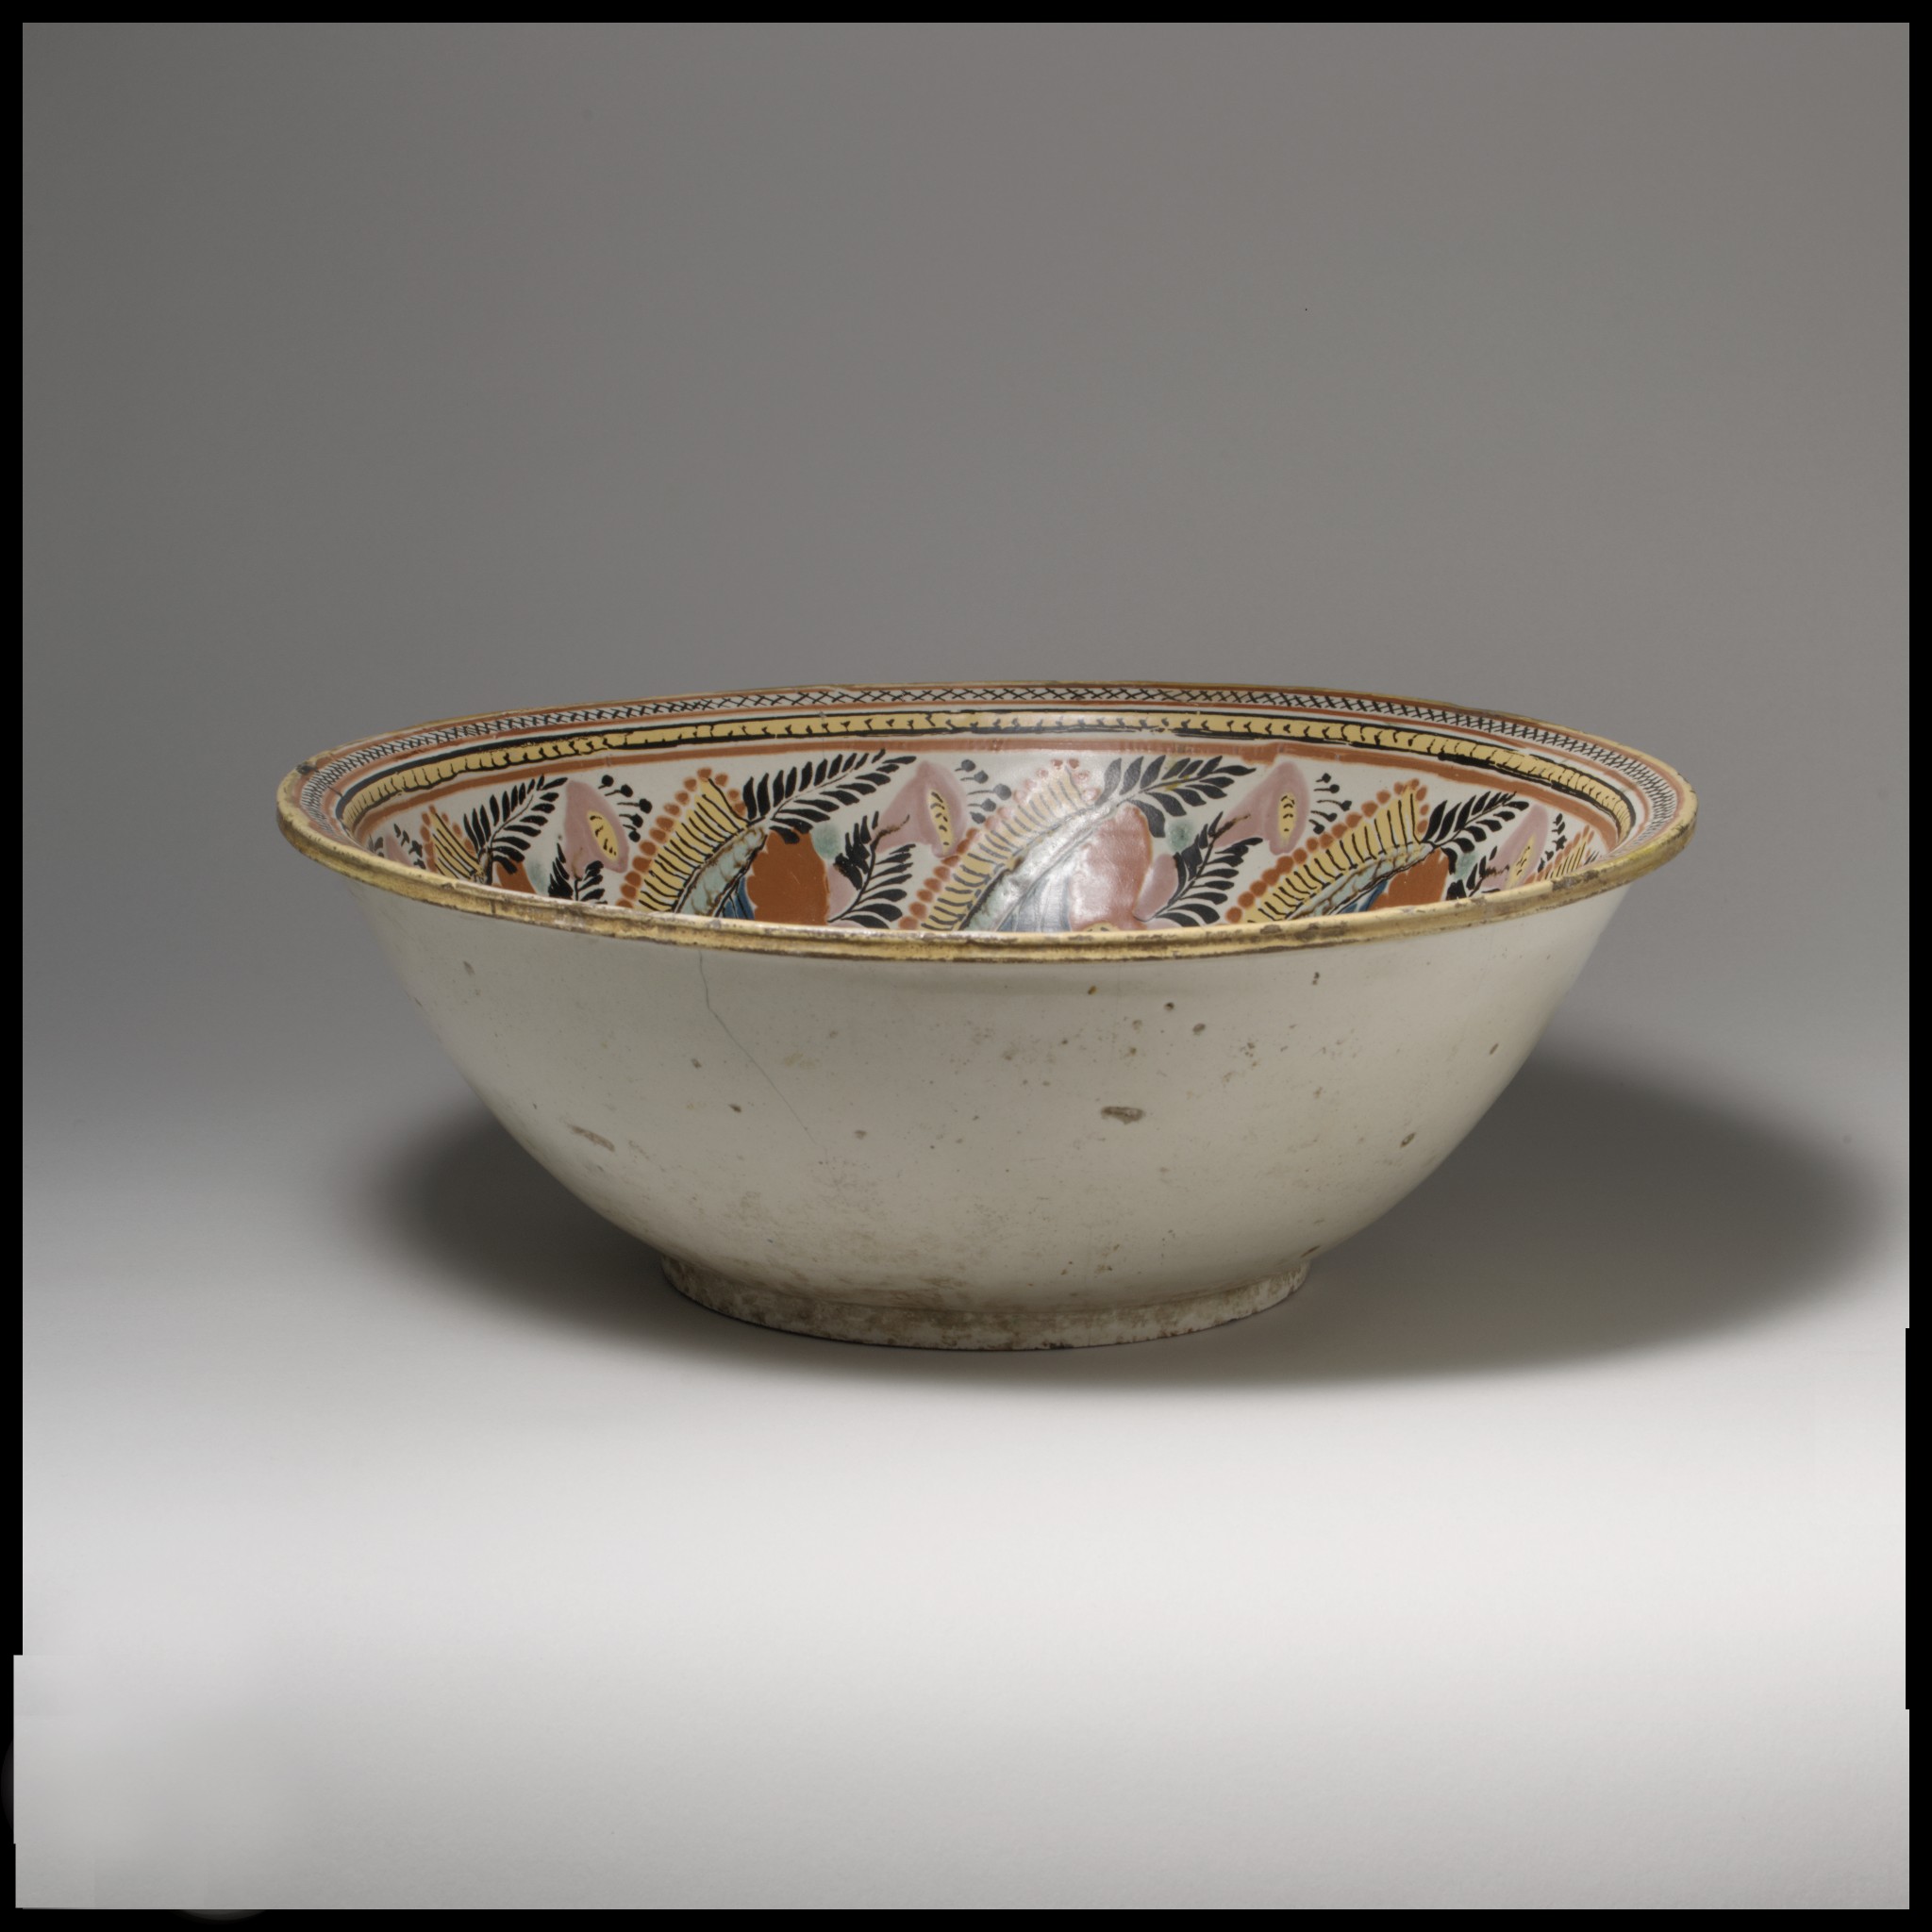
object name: bowl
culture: mexican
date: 1840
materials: earthenware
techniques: glazing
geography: mexico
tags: flowers